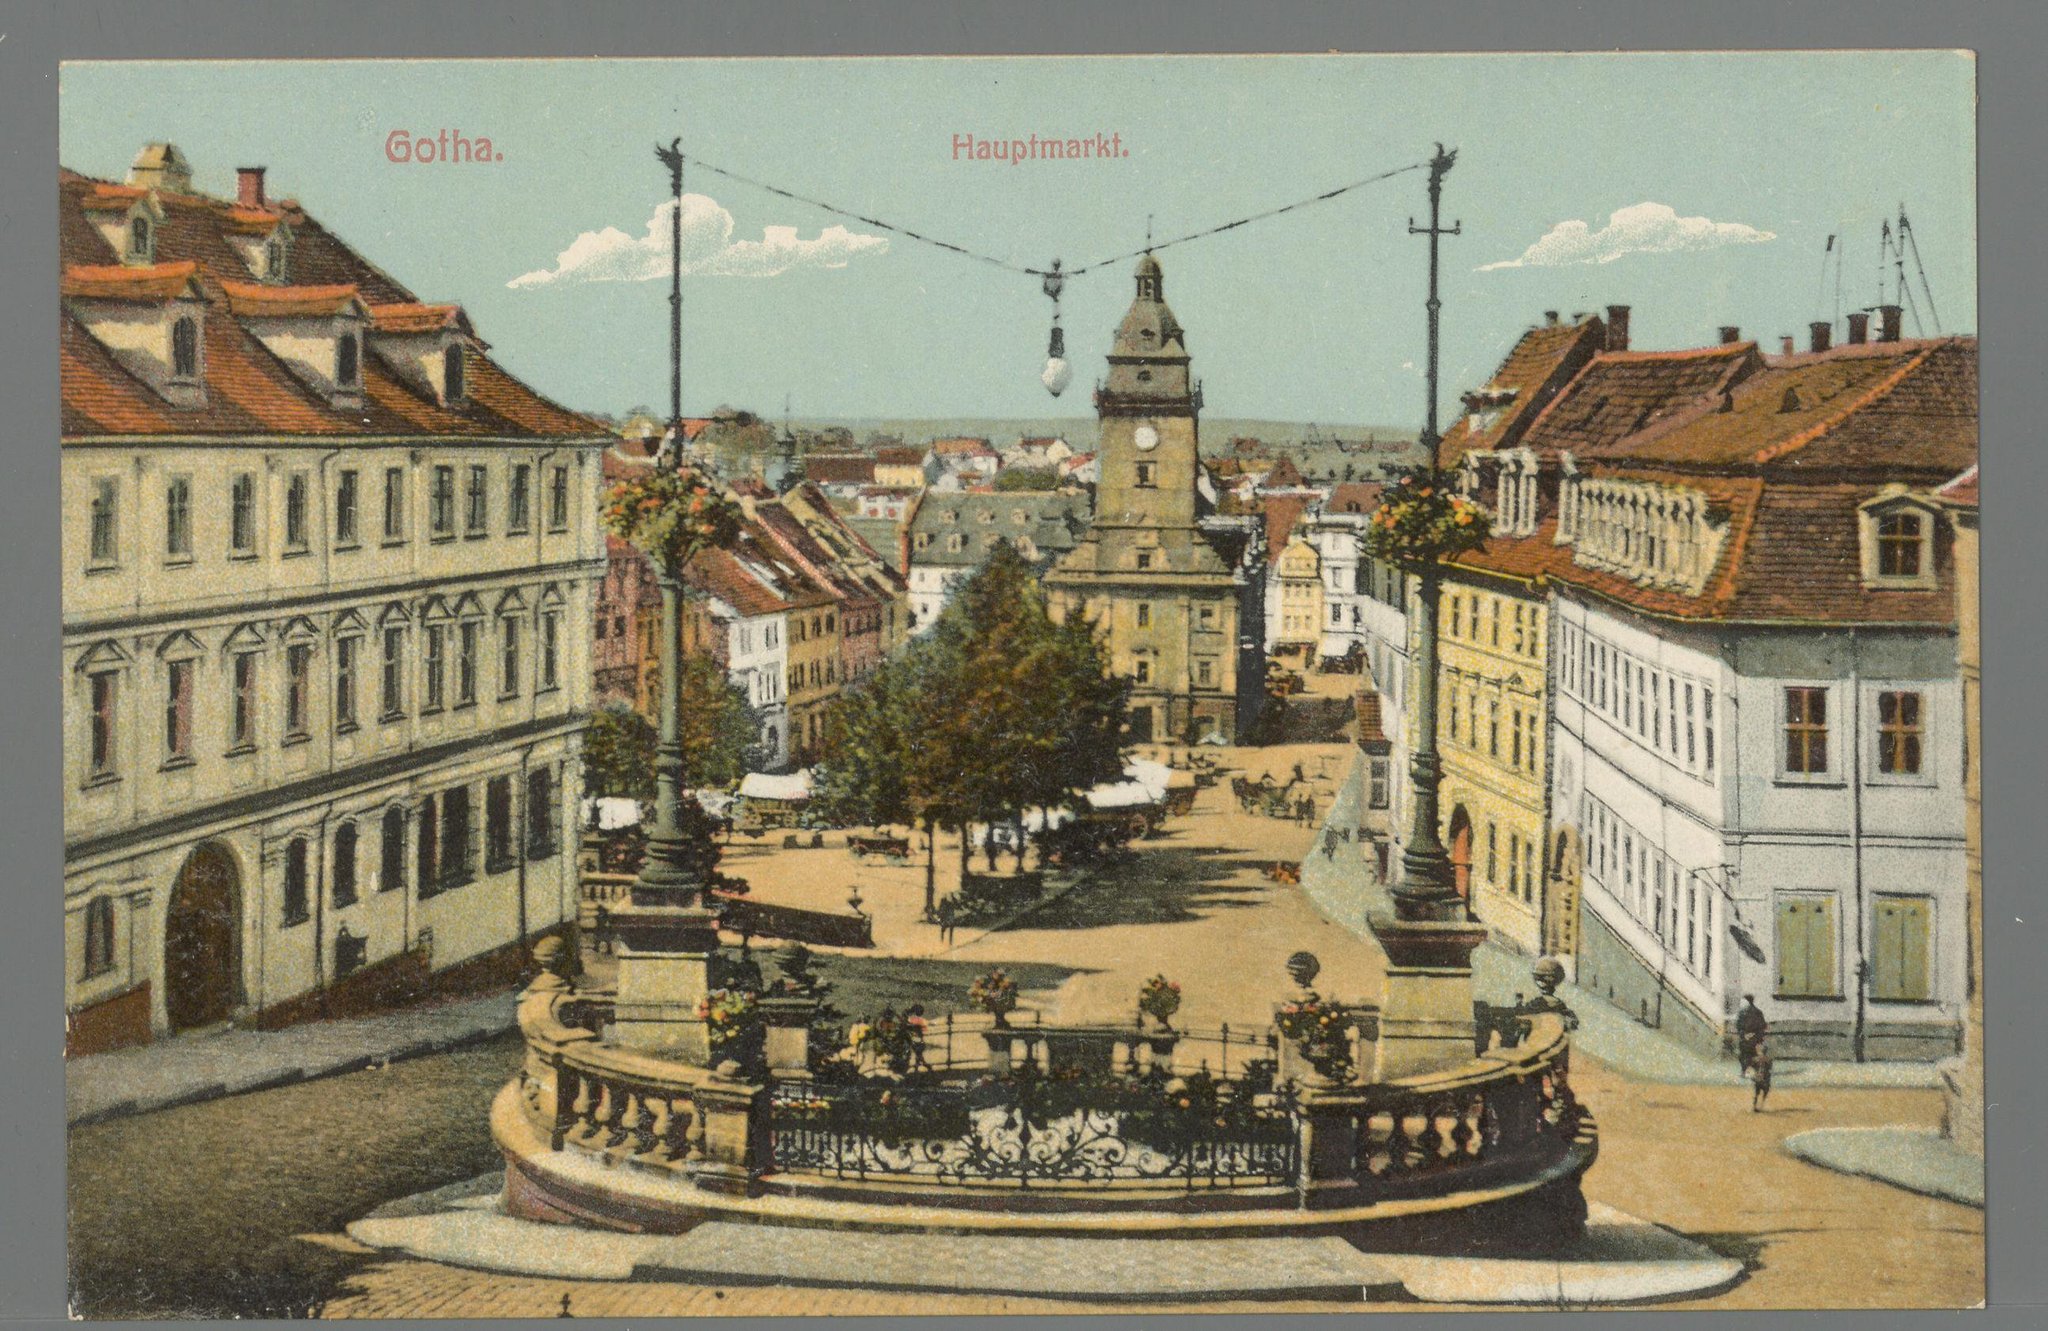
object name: photomechanical print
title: Gotha. Hauptmarkt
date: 1905-1930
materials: cardboard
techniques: photograph, lithograph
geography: gotha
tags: square, place, circus, etc., townhall